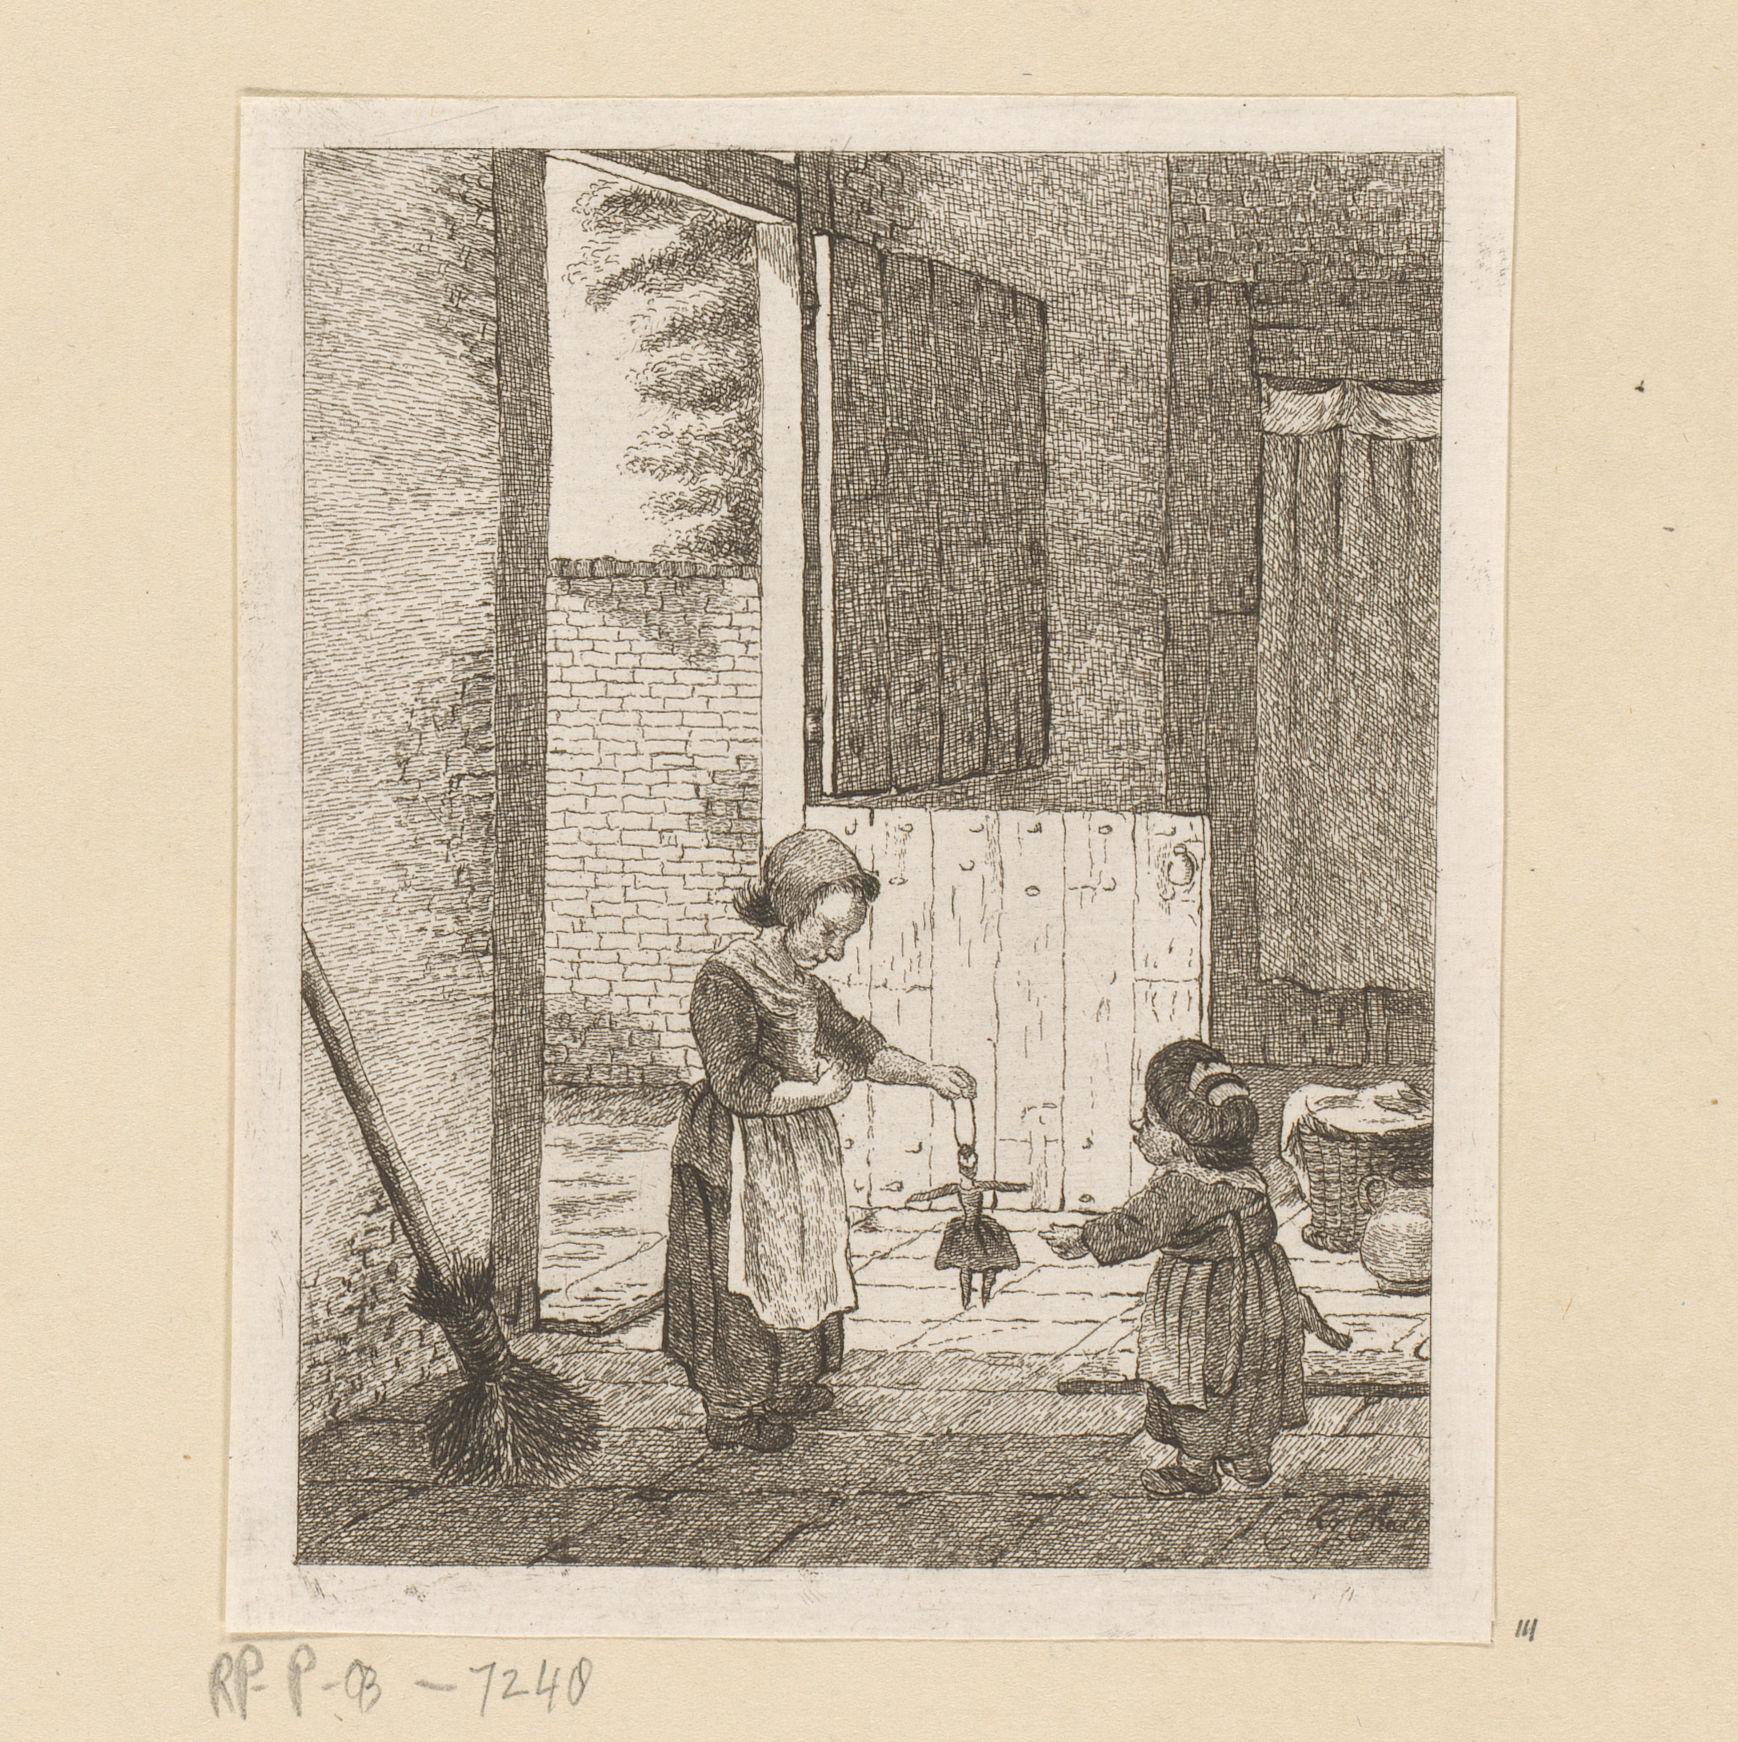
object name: print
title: Twee meisjes spelend met een pop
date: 1779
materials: paper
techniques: etching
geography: leiden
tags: kitchen-interior, (playing with) dolls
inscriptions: collector's mark: Lugt 2228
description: Twee meisjes spelen met een pop in de keuken. Een deur naar de buitenplaats staat open. Op de grond een mand wasgoed en tegen de muur een bezem.